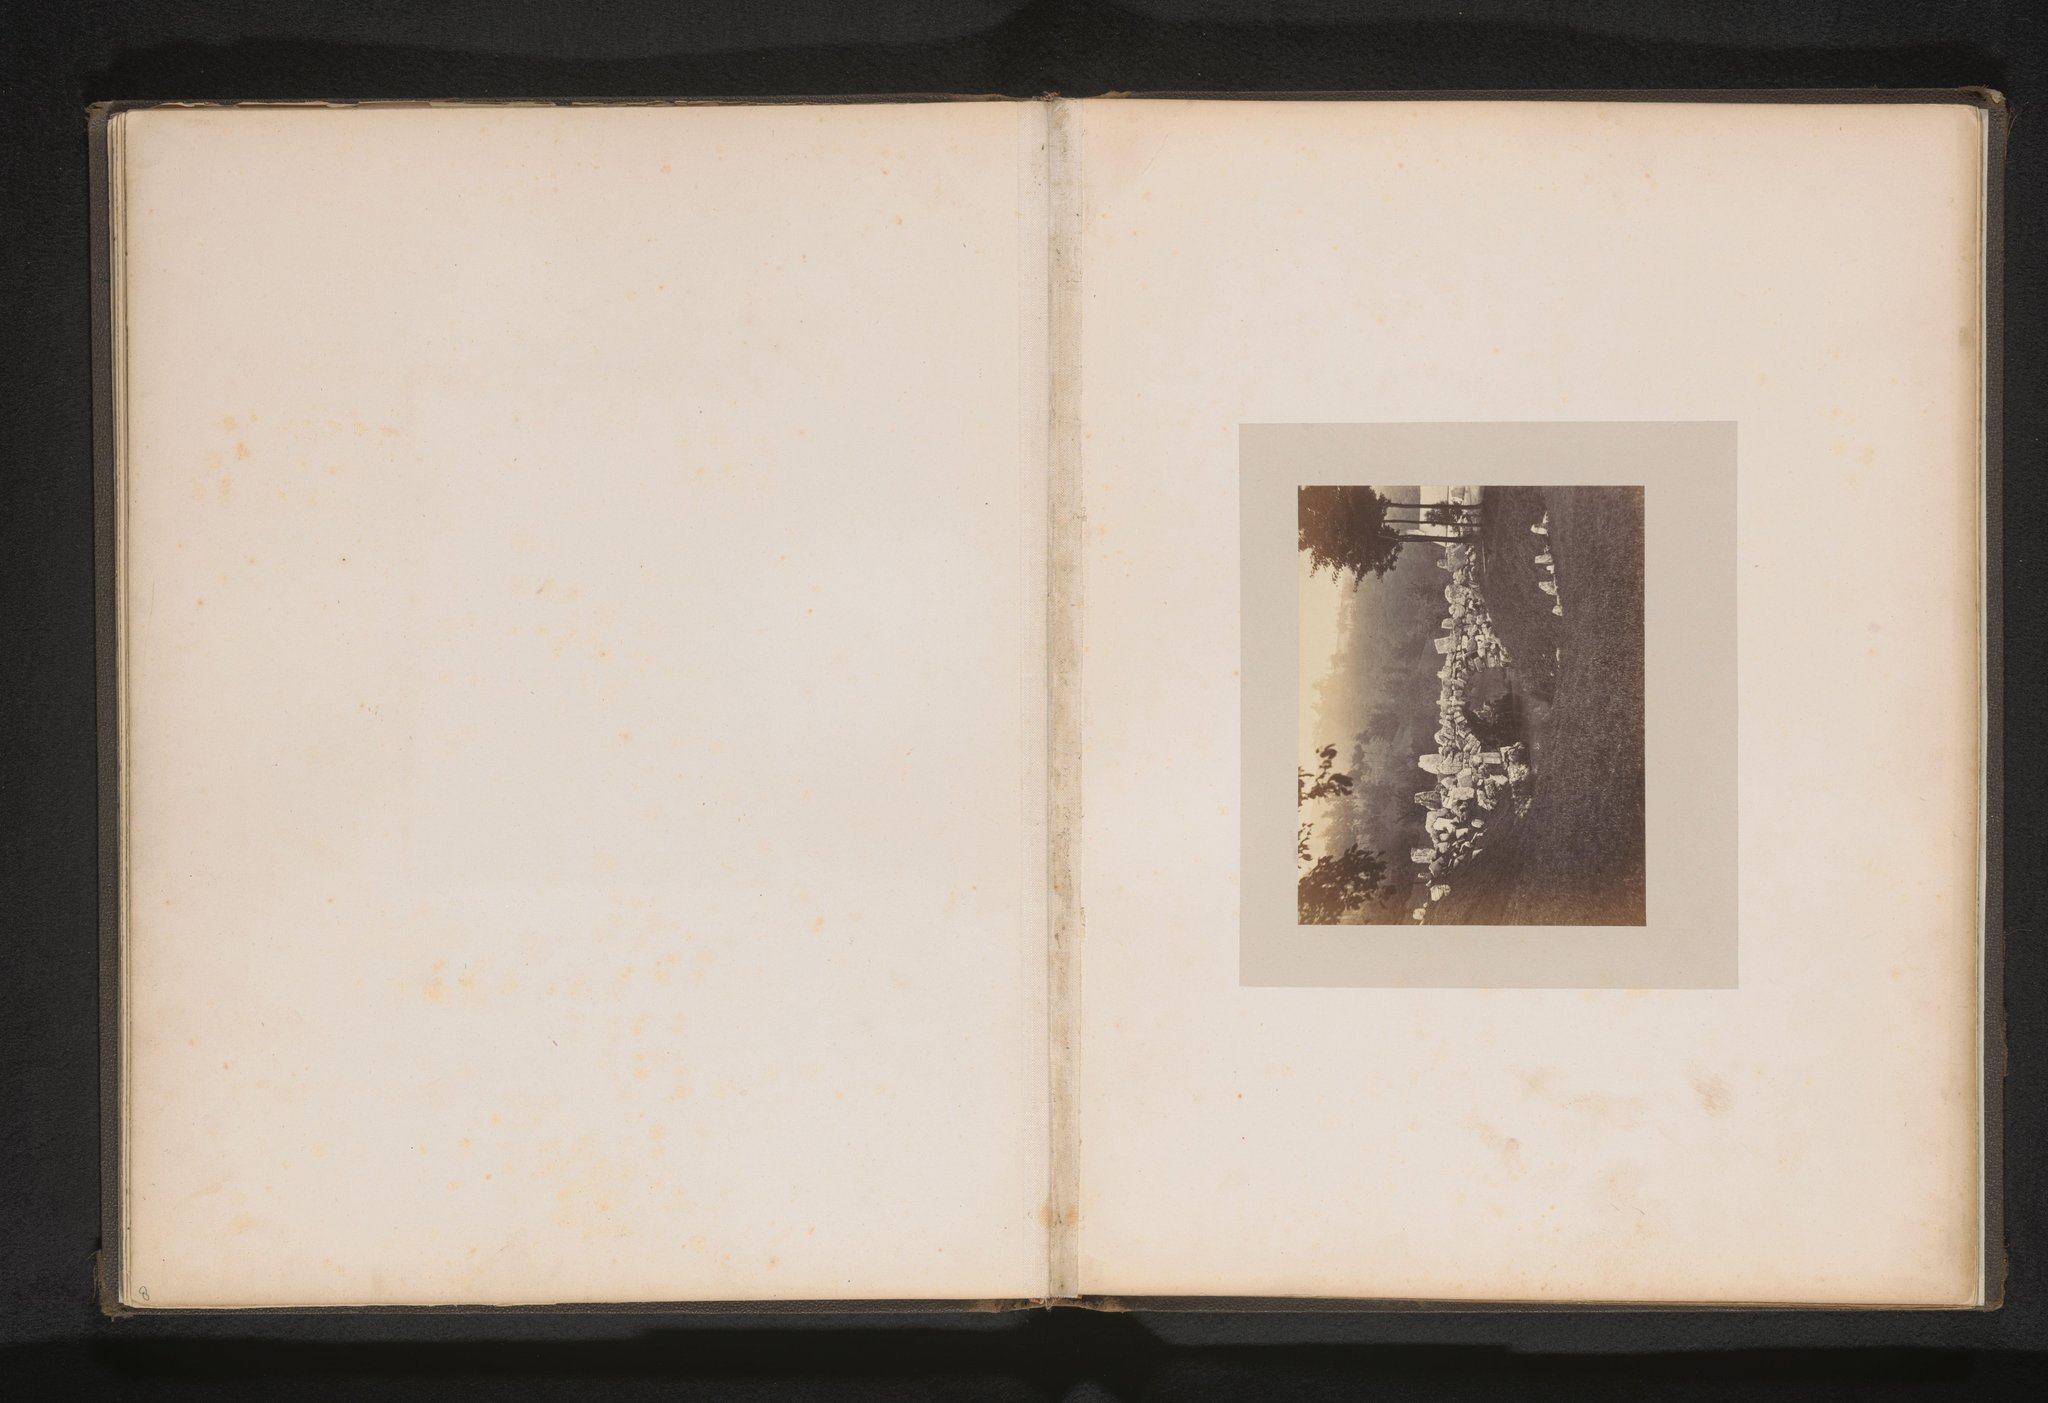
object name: photograph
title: Gezicht op een stenen brug nabij Château de Marlagne te Wépion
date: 1862-1867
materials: photographic support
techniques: albumen print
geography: wépion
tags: castle, bridge